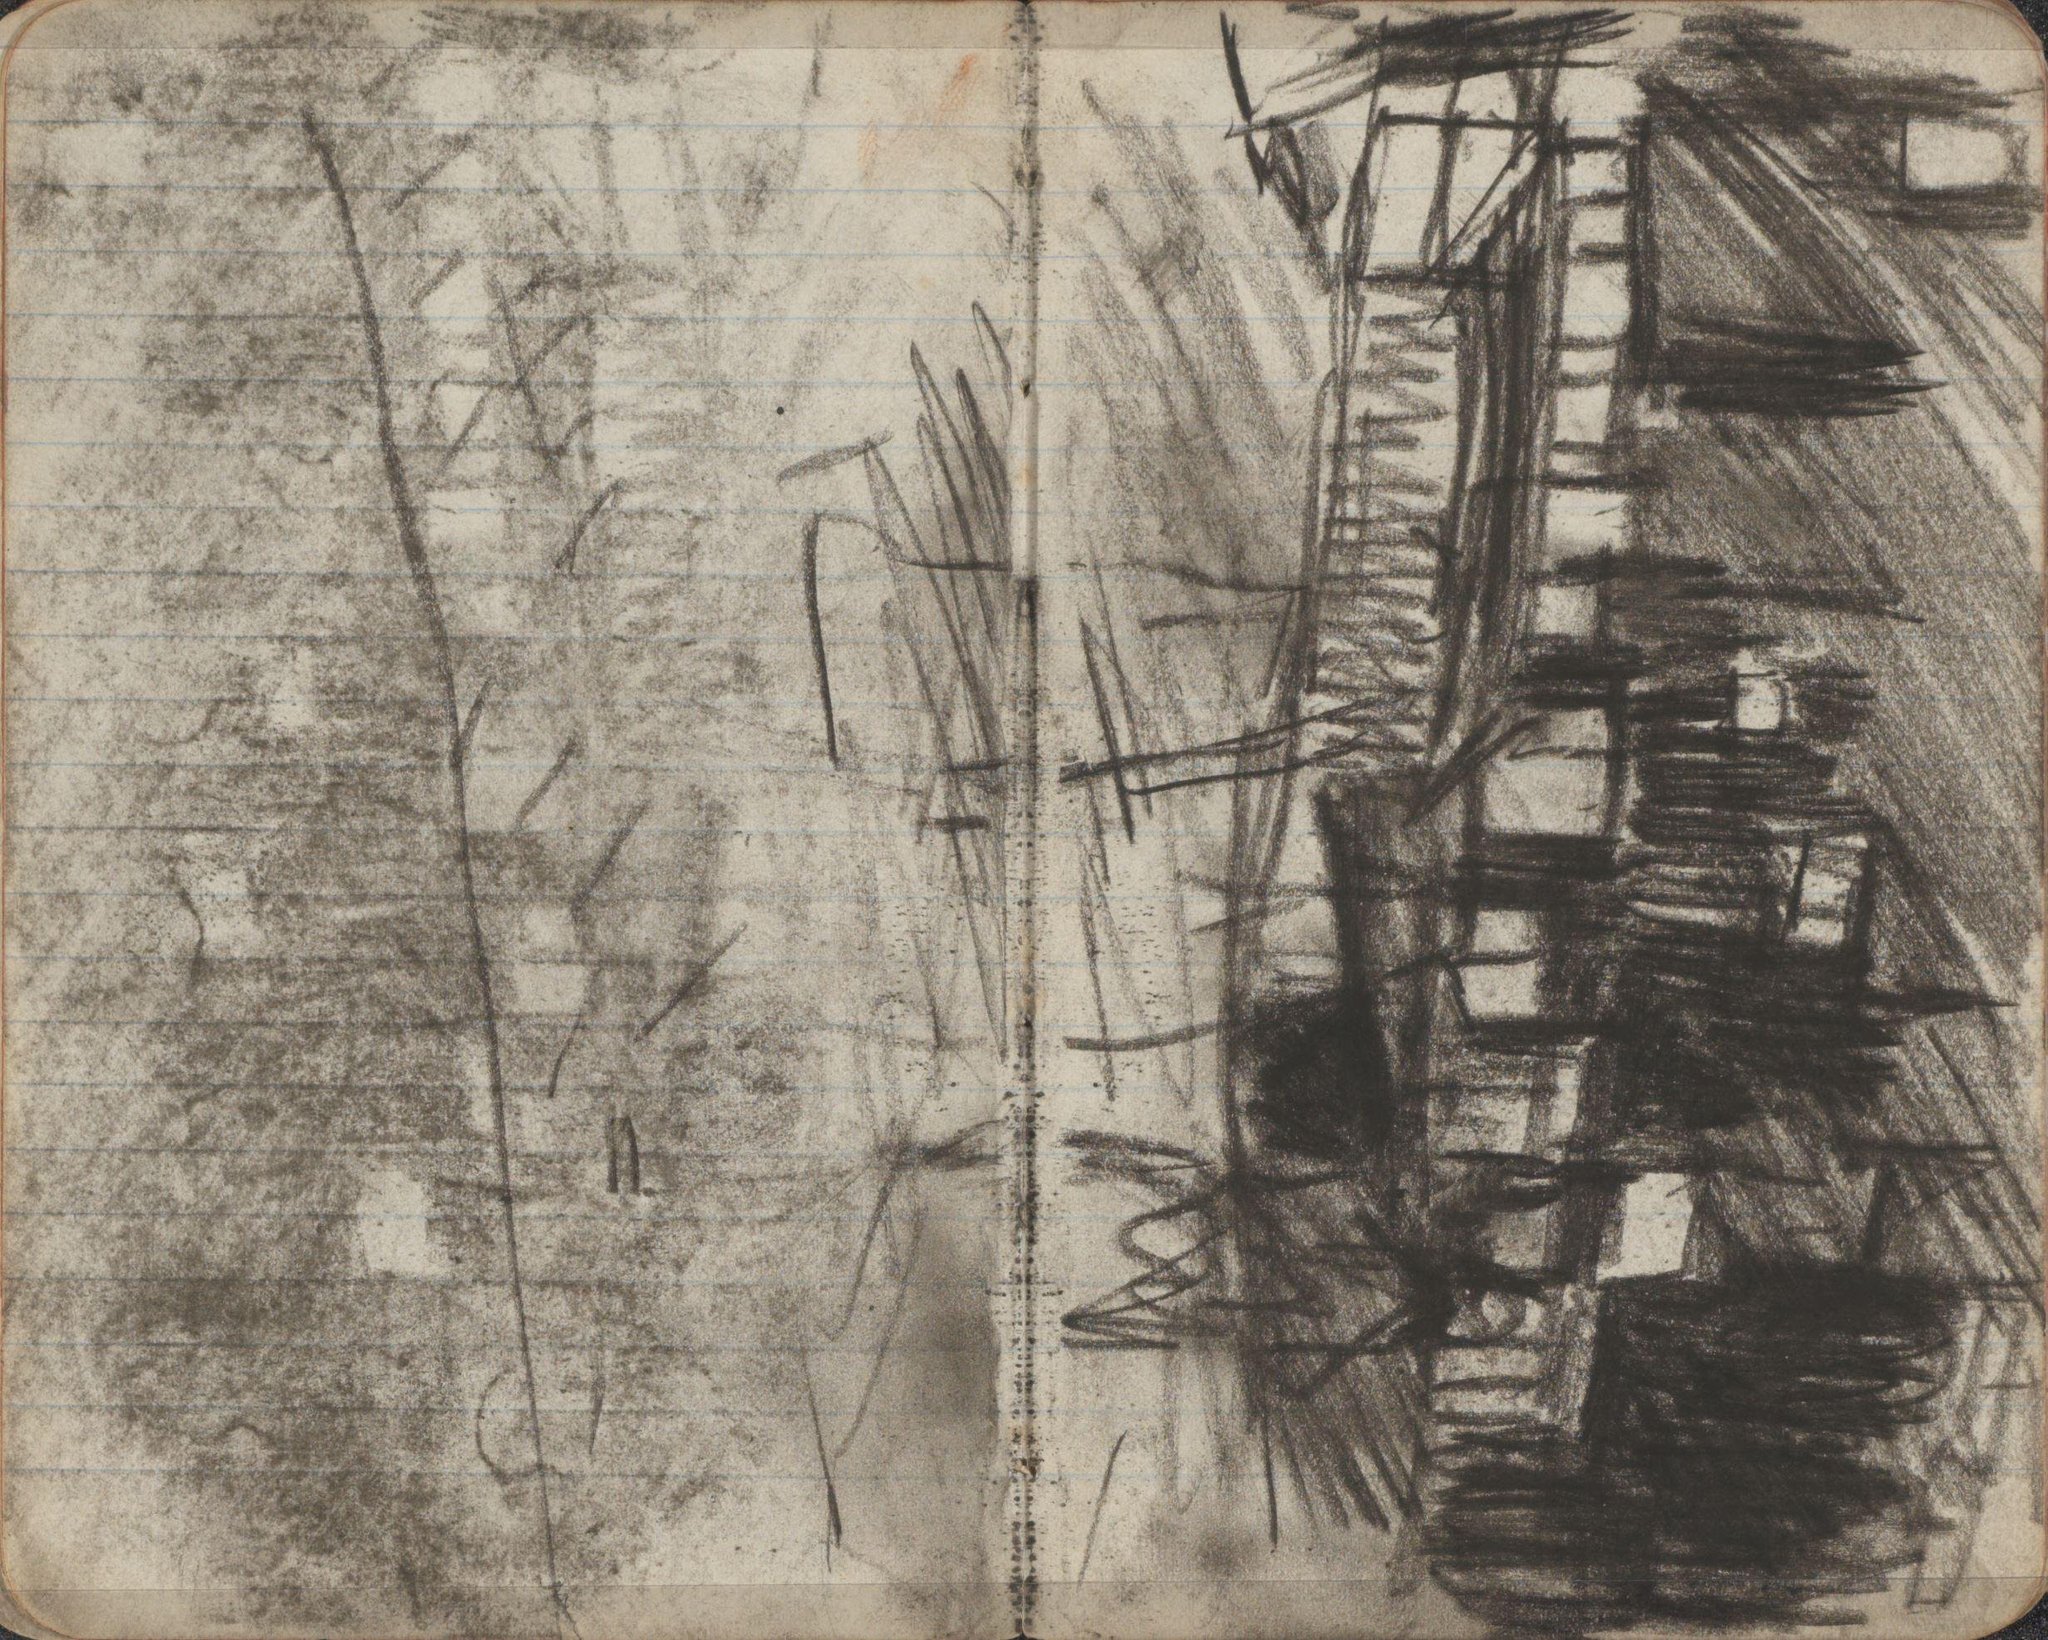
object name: sketchbook leaf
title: Gezicht te Amsterdam, mogelijk de Prinsengracht ter hoogte van de Reesluis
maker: george hendrik breitner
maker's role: draughtsman, painter, print maker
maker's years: 1857-1923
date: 1893-1894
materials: chalk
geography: amsterdam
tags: bridge in city across river, canal, etc. (+ city(-scape) with figures, staffage)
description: Vooraan figuren. Pagina 20 en pagina 21 uit een schetsboek met 36 bladen.